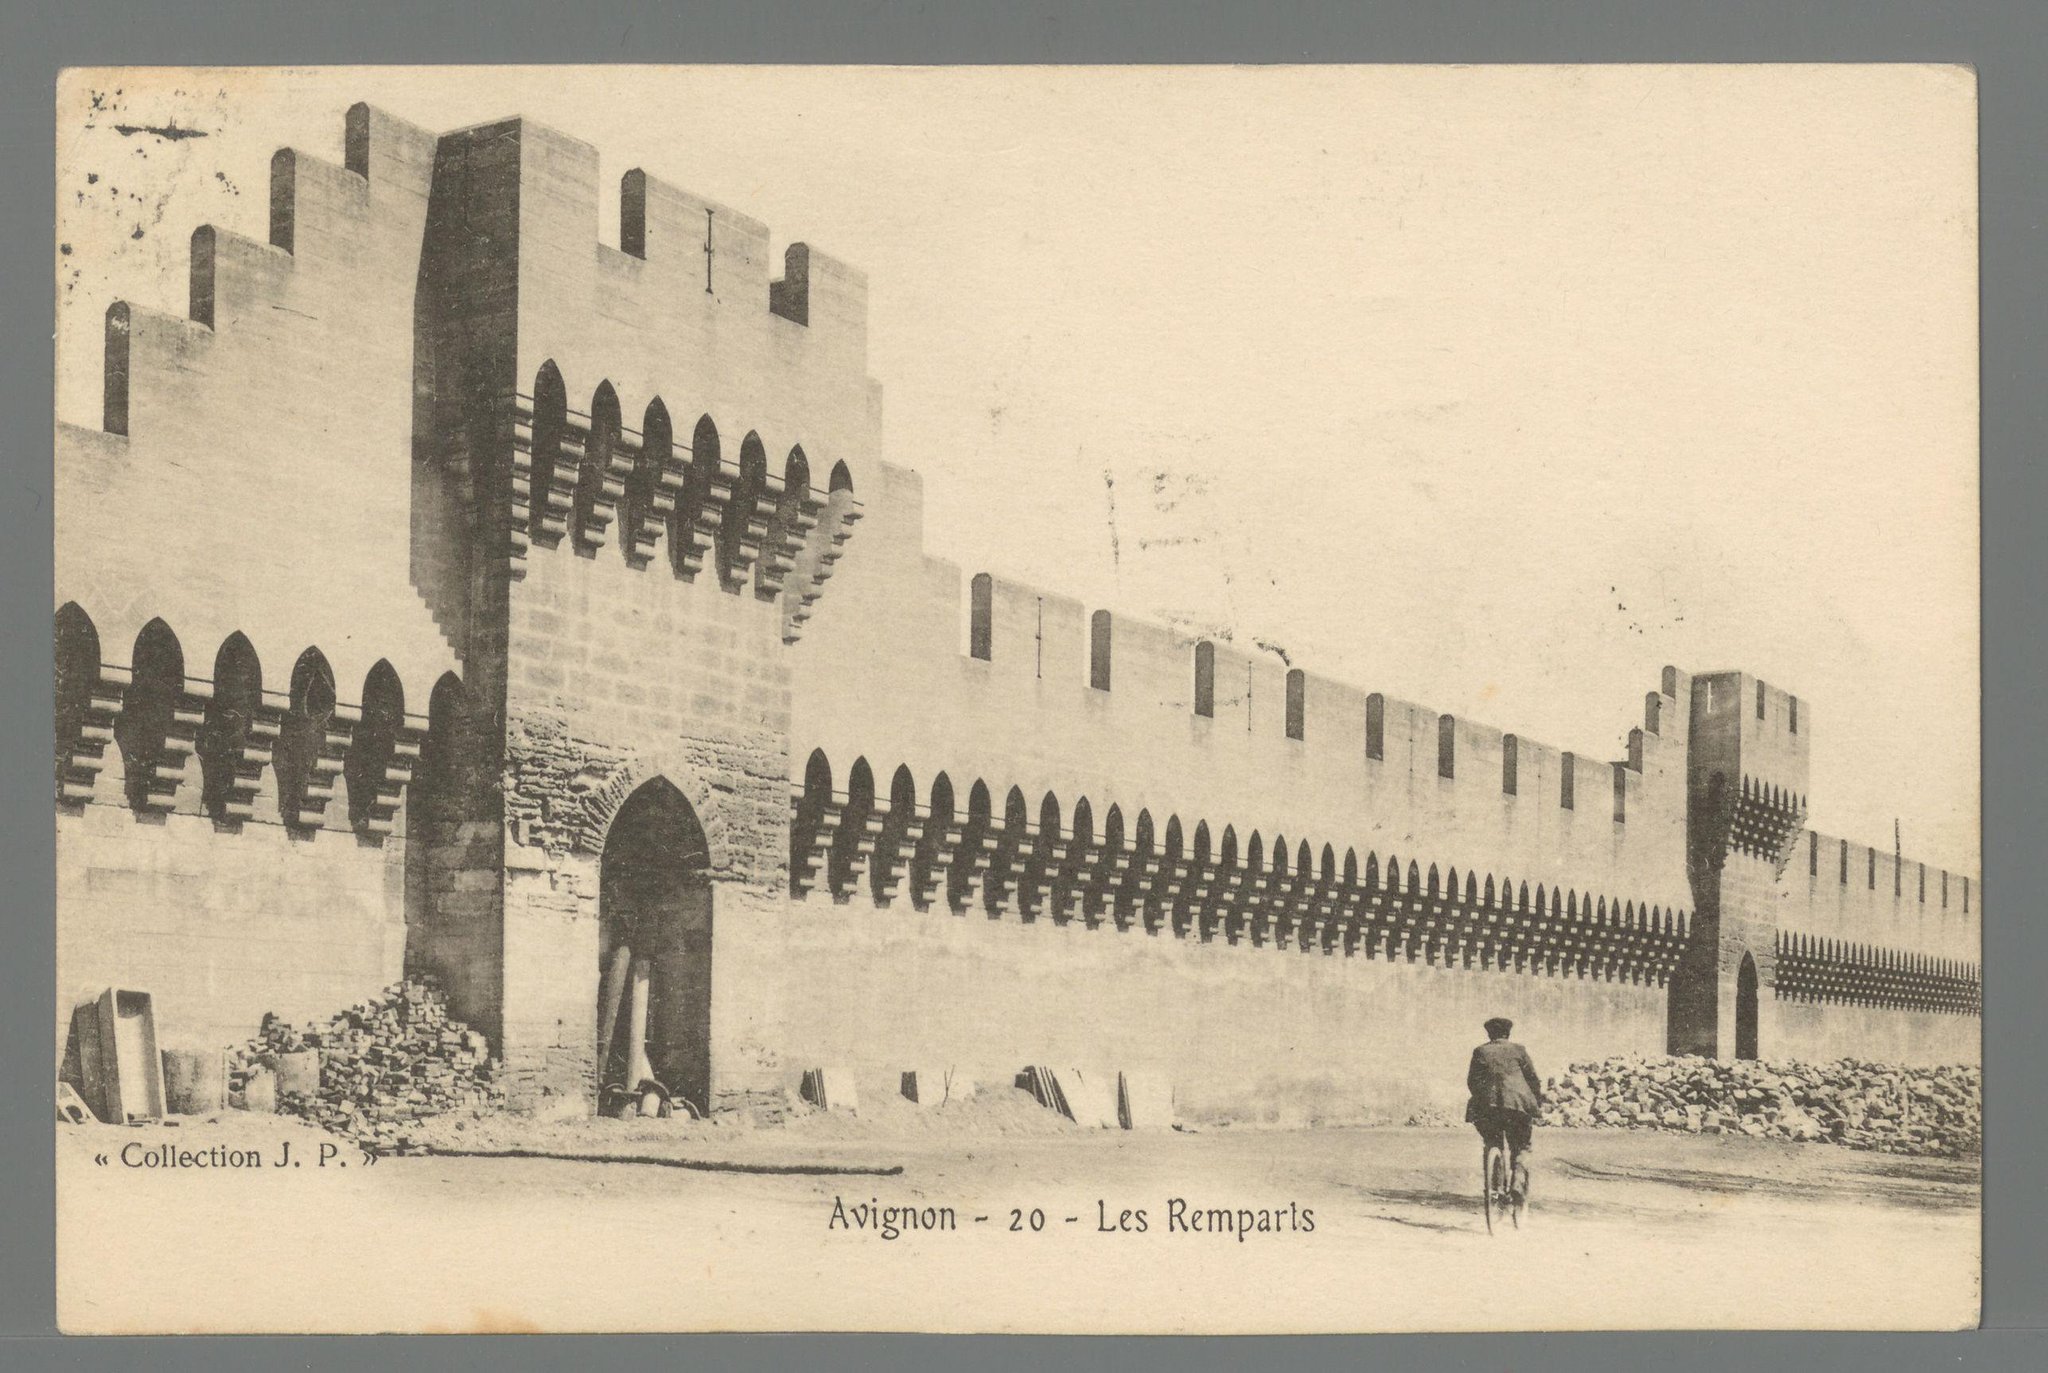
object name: photomechanical print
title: Avignon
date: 1892-1903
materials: cardboard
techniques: photograph, writing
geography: avignon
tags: bicycle (+ one person ~ traffic and transport), city-walls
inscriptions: monogram: ‘J.P.’